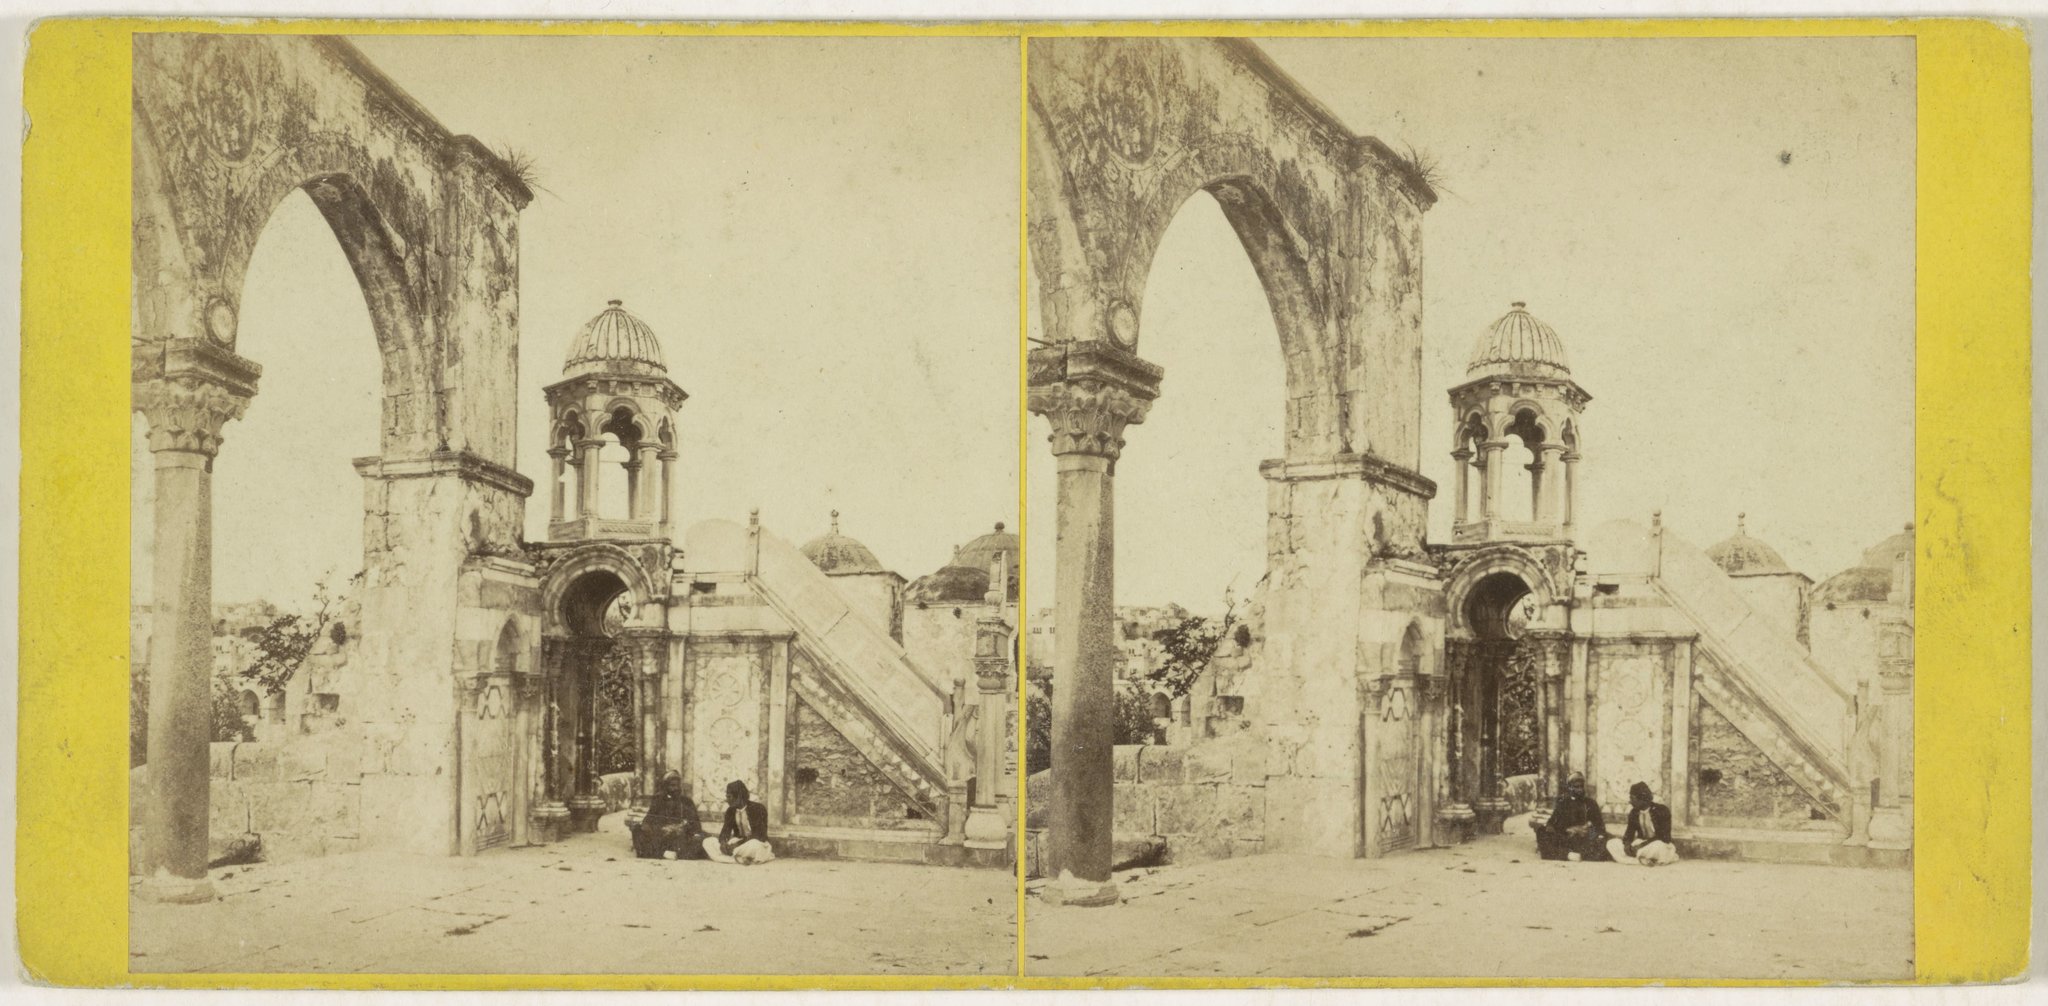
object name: stereograph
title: Minbar op de binnenplaats van de Omarmoskee, Jeruzalem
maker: frank mason good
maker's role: publisher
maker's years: 1839-1928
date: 1866-1875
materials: cardboard, paper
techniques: albumen print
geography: london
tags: temple, shrine ~ islam, mohammedanism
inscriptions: number: ‘No. 33A.’